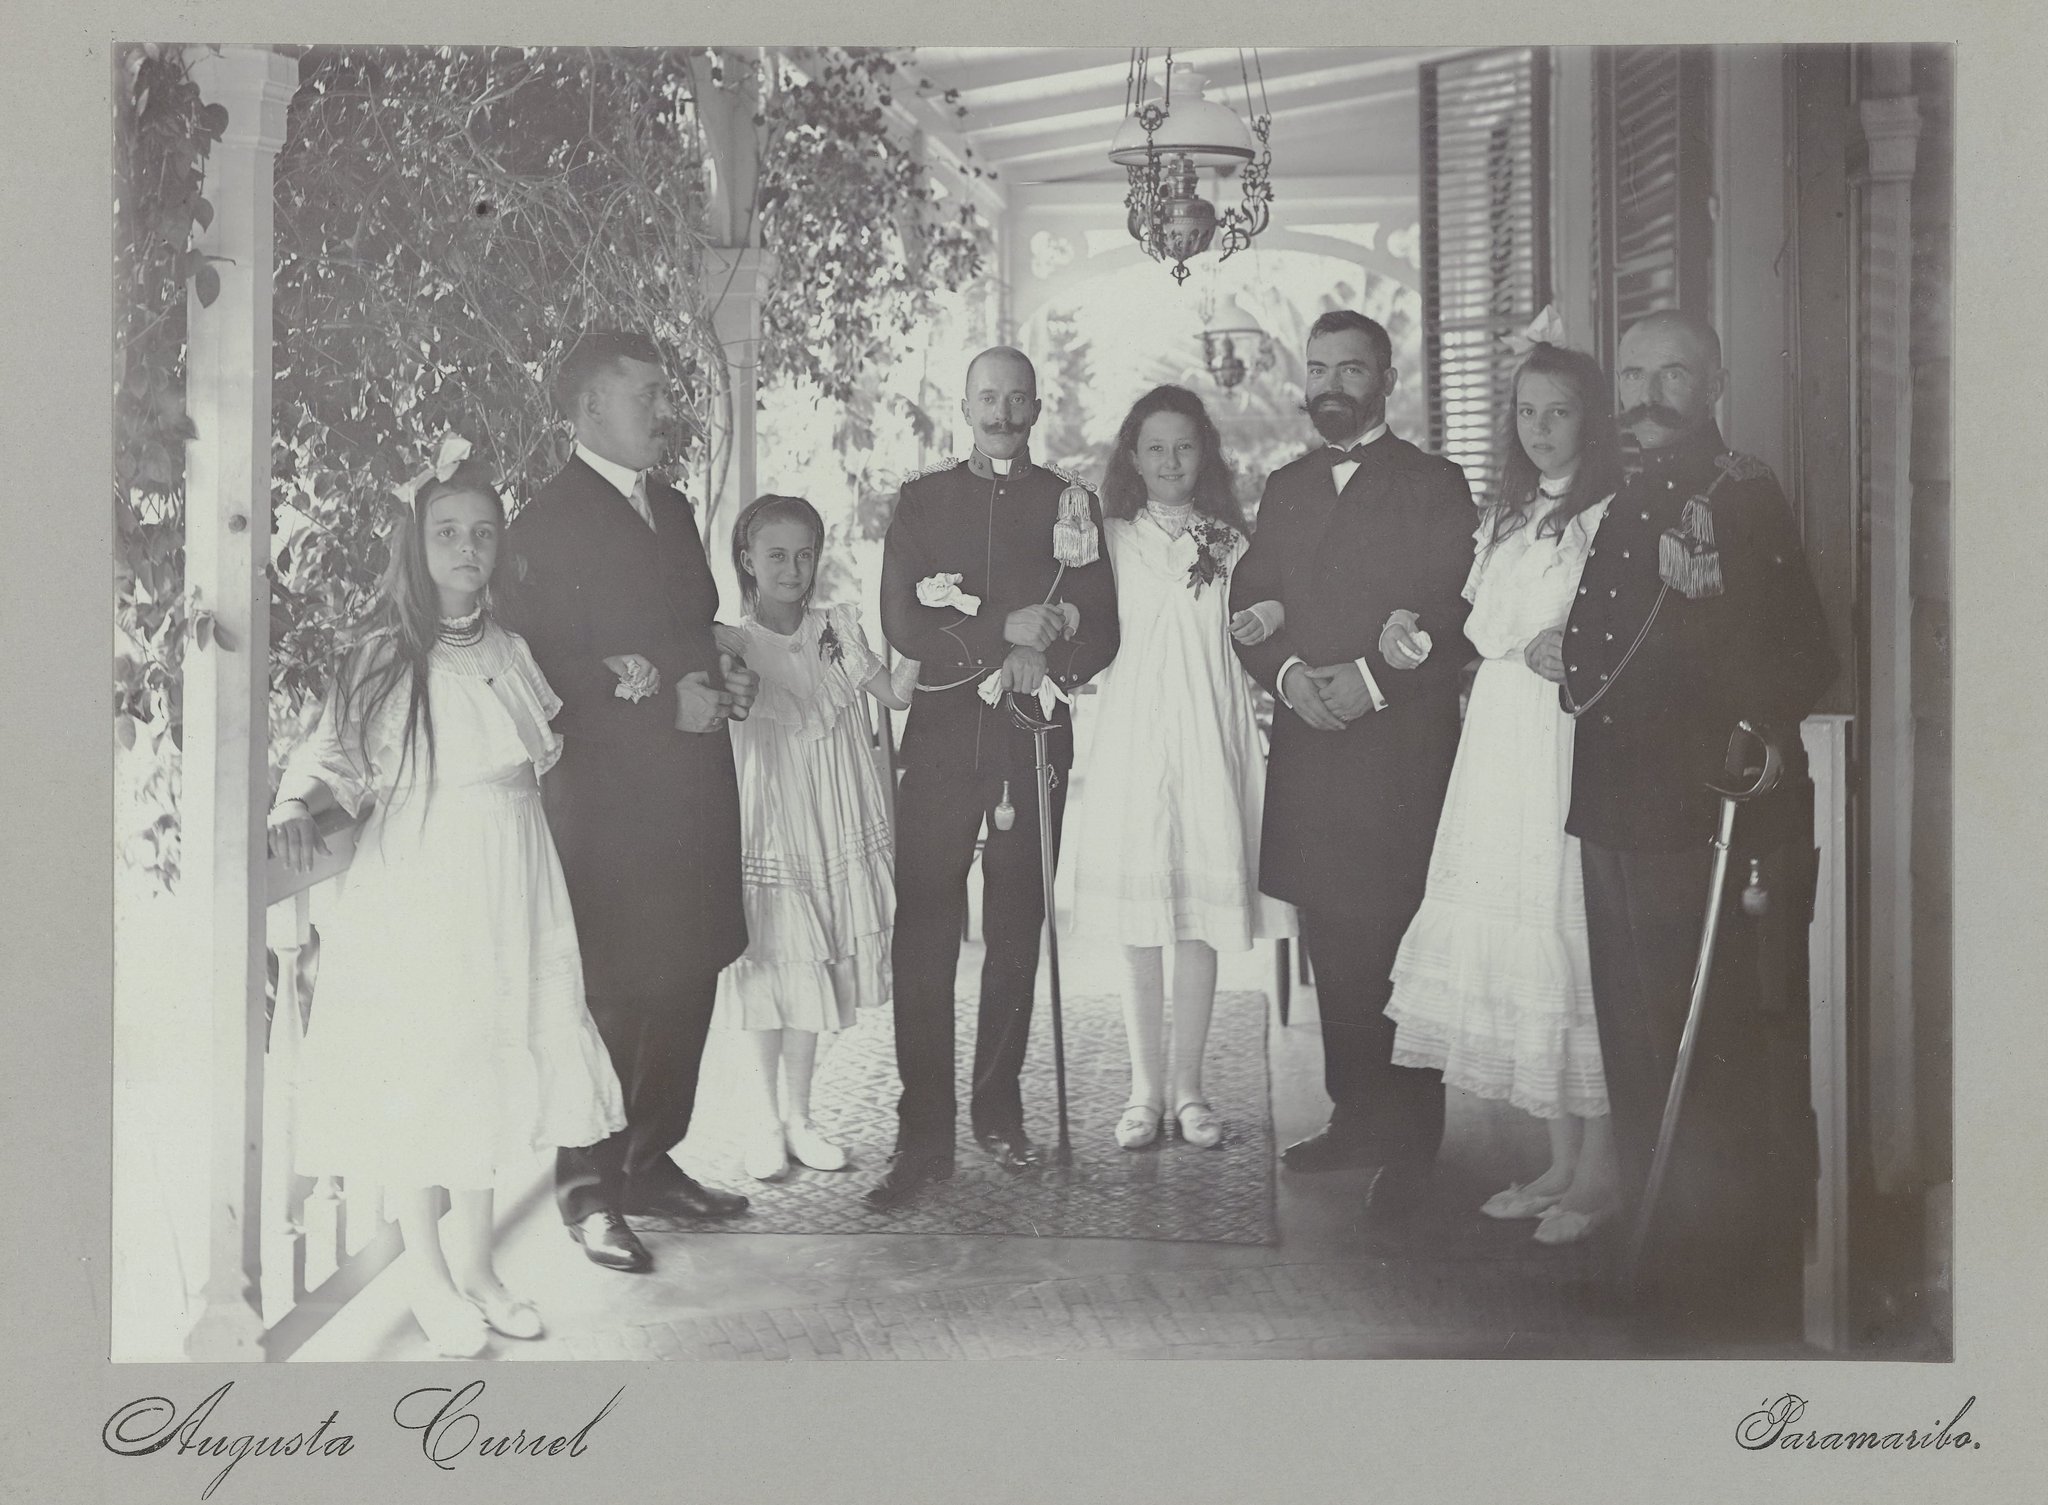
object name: photograph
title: Bruiloft te Paramaribo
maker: augusta curiel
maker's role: fotograaf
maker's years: 1873-1937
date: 1903-1908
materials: photographic support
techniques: photography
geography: paramaribo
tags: (civil) marriage ceremonies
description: Op een waranda staat een groep feestelijk geklede mensen. De vier jonge meisjes zijn waarschijnlijk de bruidsmeisjes. Bruiloft te Paramaribo, Suriname.